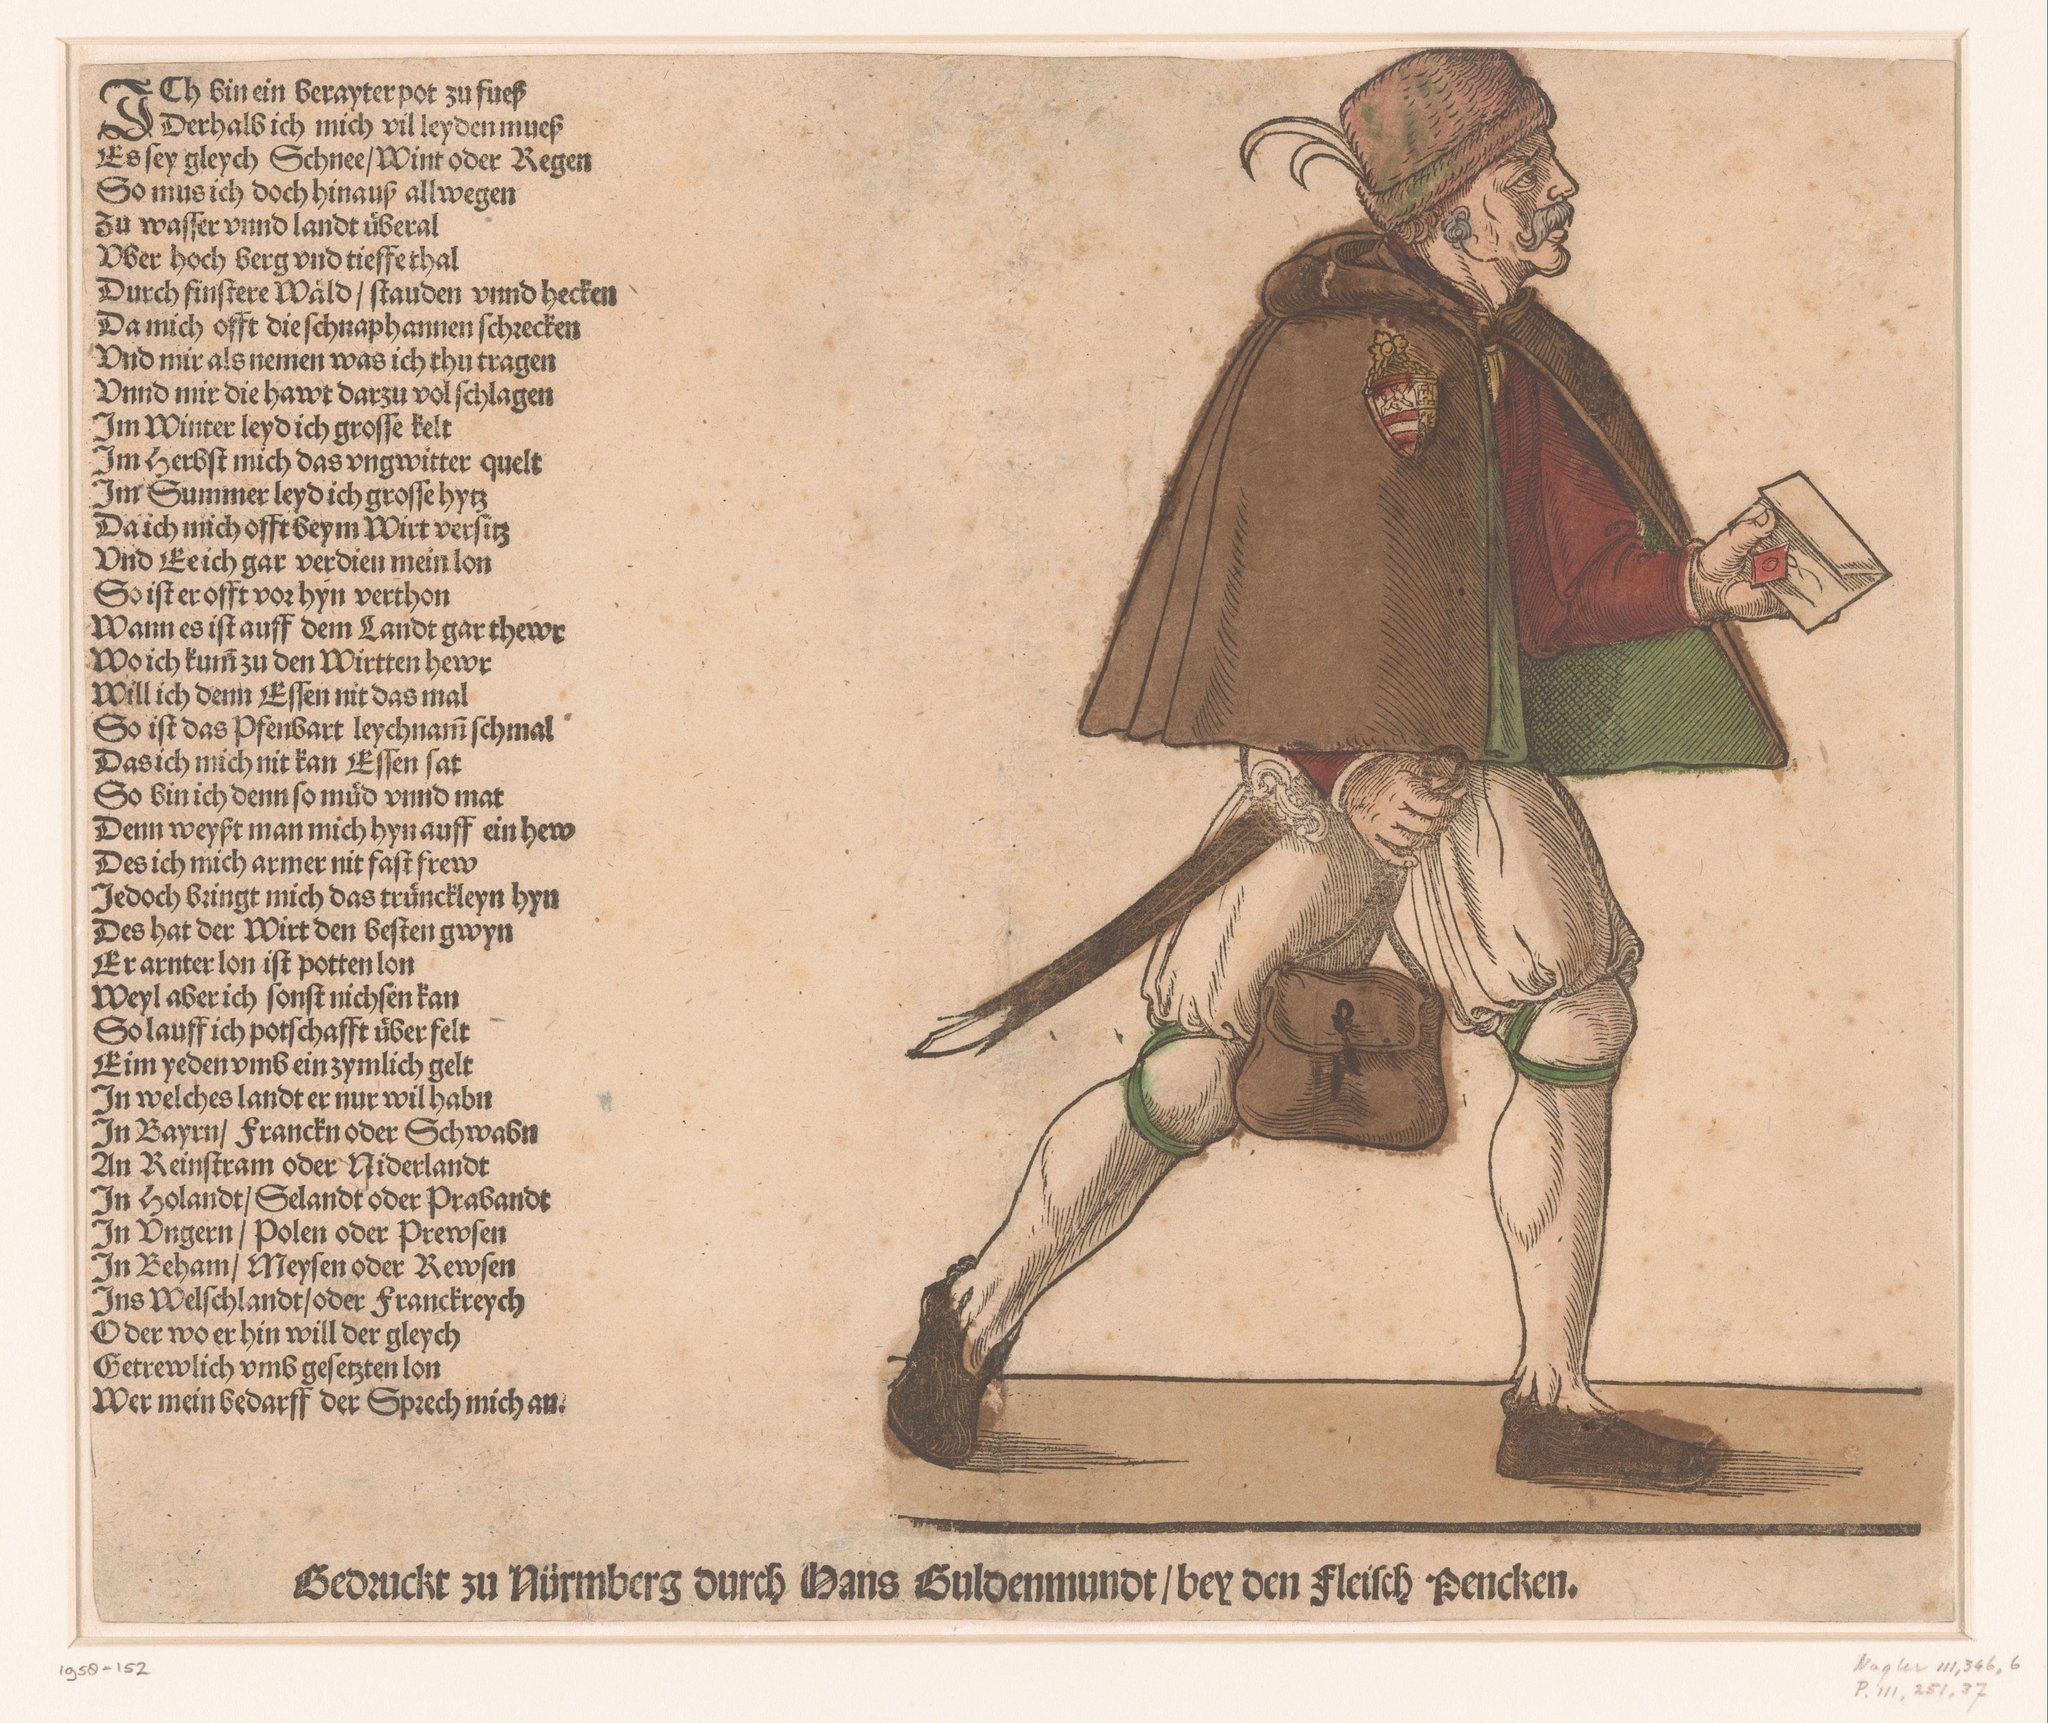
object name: print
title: Bode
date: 1520-1550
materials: paper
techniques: hand coloring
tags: postman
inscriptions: collector's mark: Lugt 2228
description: Een bode, lopend naar rechts, brief met lakzegel in de linkerhand, postzak in de rechterhand. Met lang gedicht over zijn ambt en over de landen die hij bezoekt.